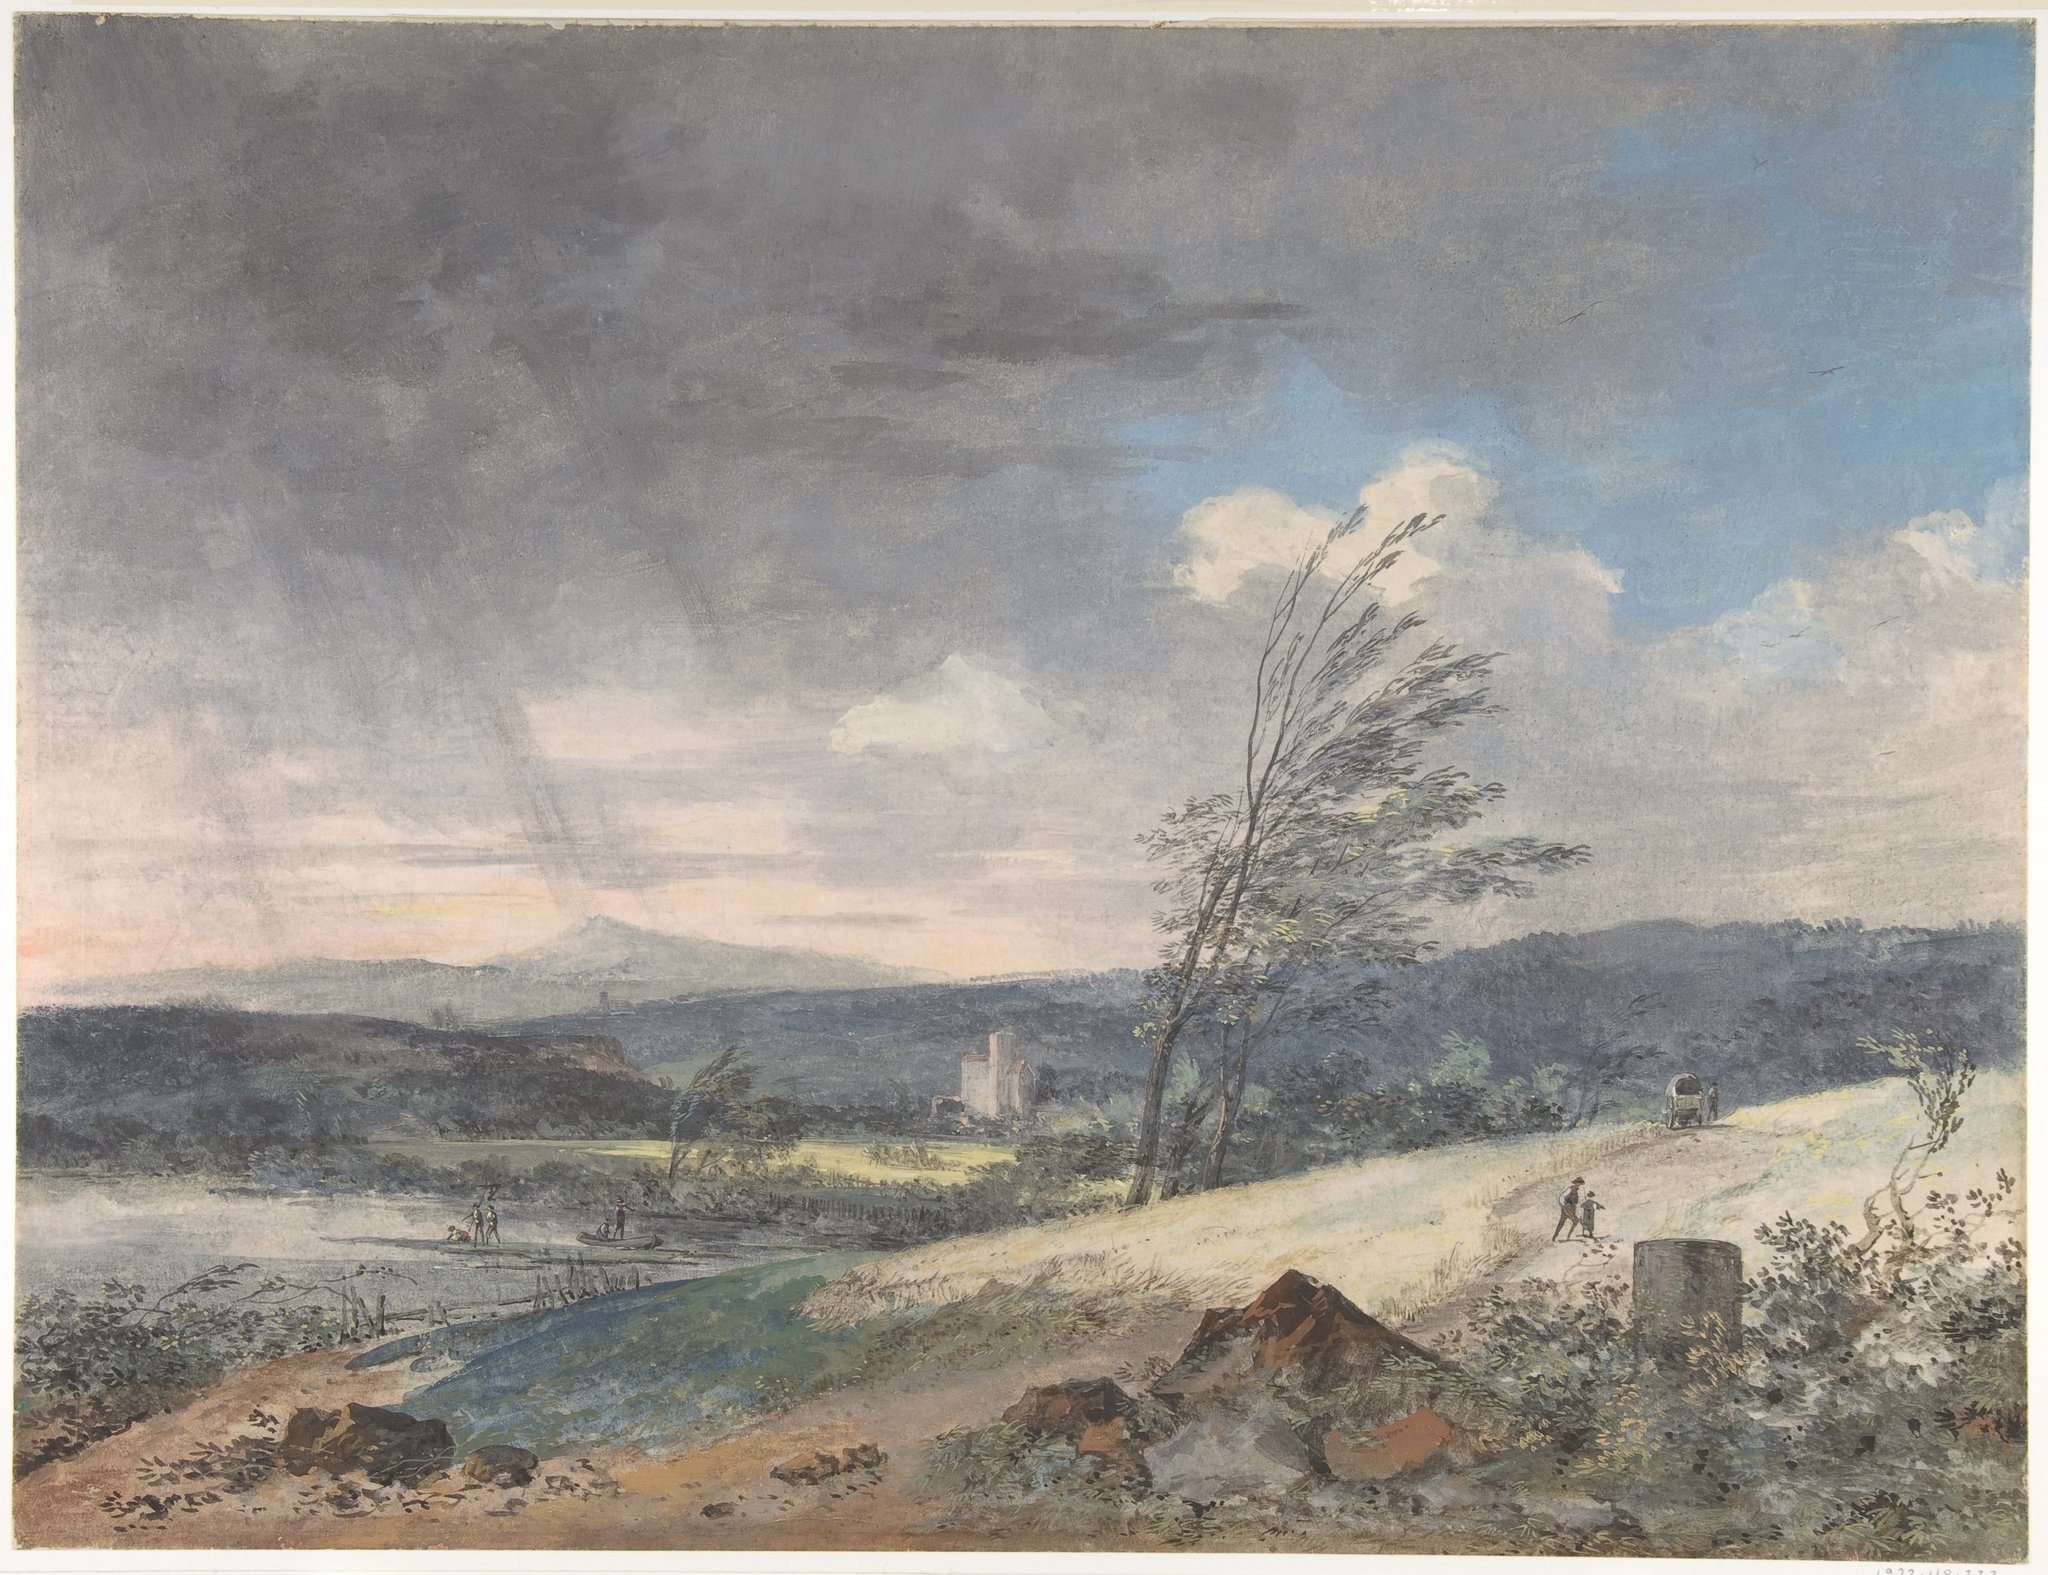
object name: drawing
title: Windswept Landscape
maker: louis gabriel moreau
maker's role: artist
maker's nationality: french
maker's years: 1740-1806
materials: chalk, gouache, watercolor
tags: hills,landscapes,trees,wind